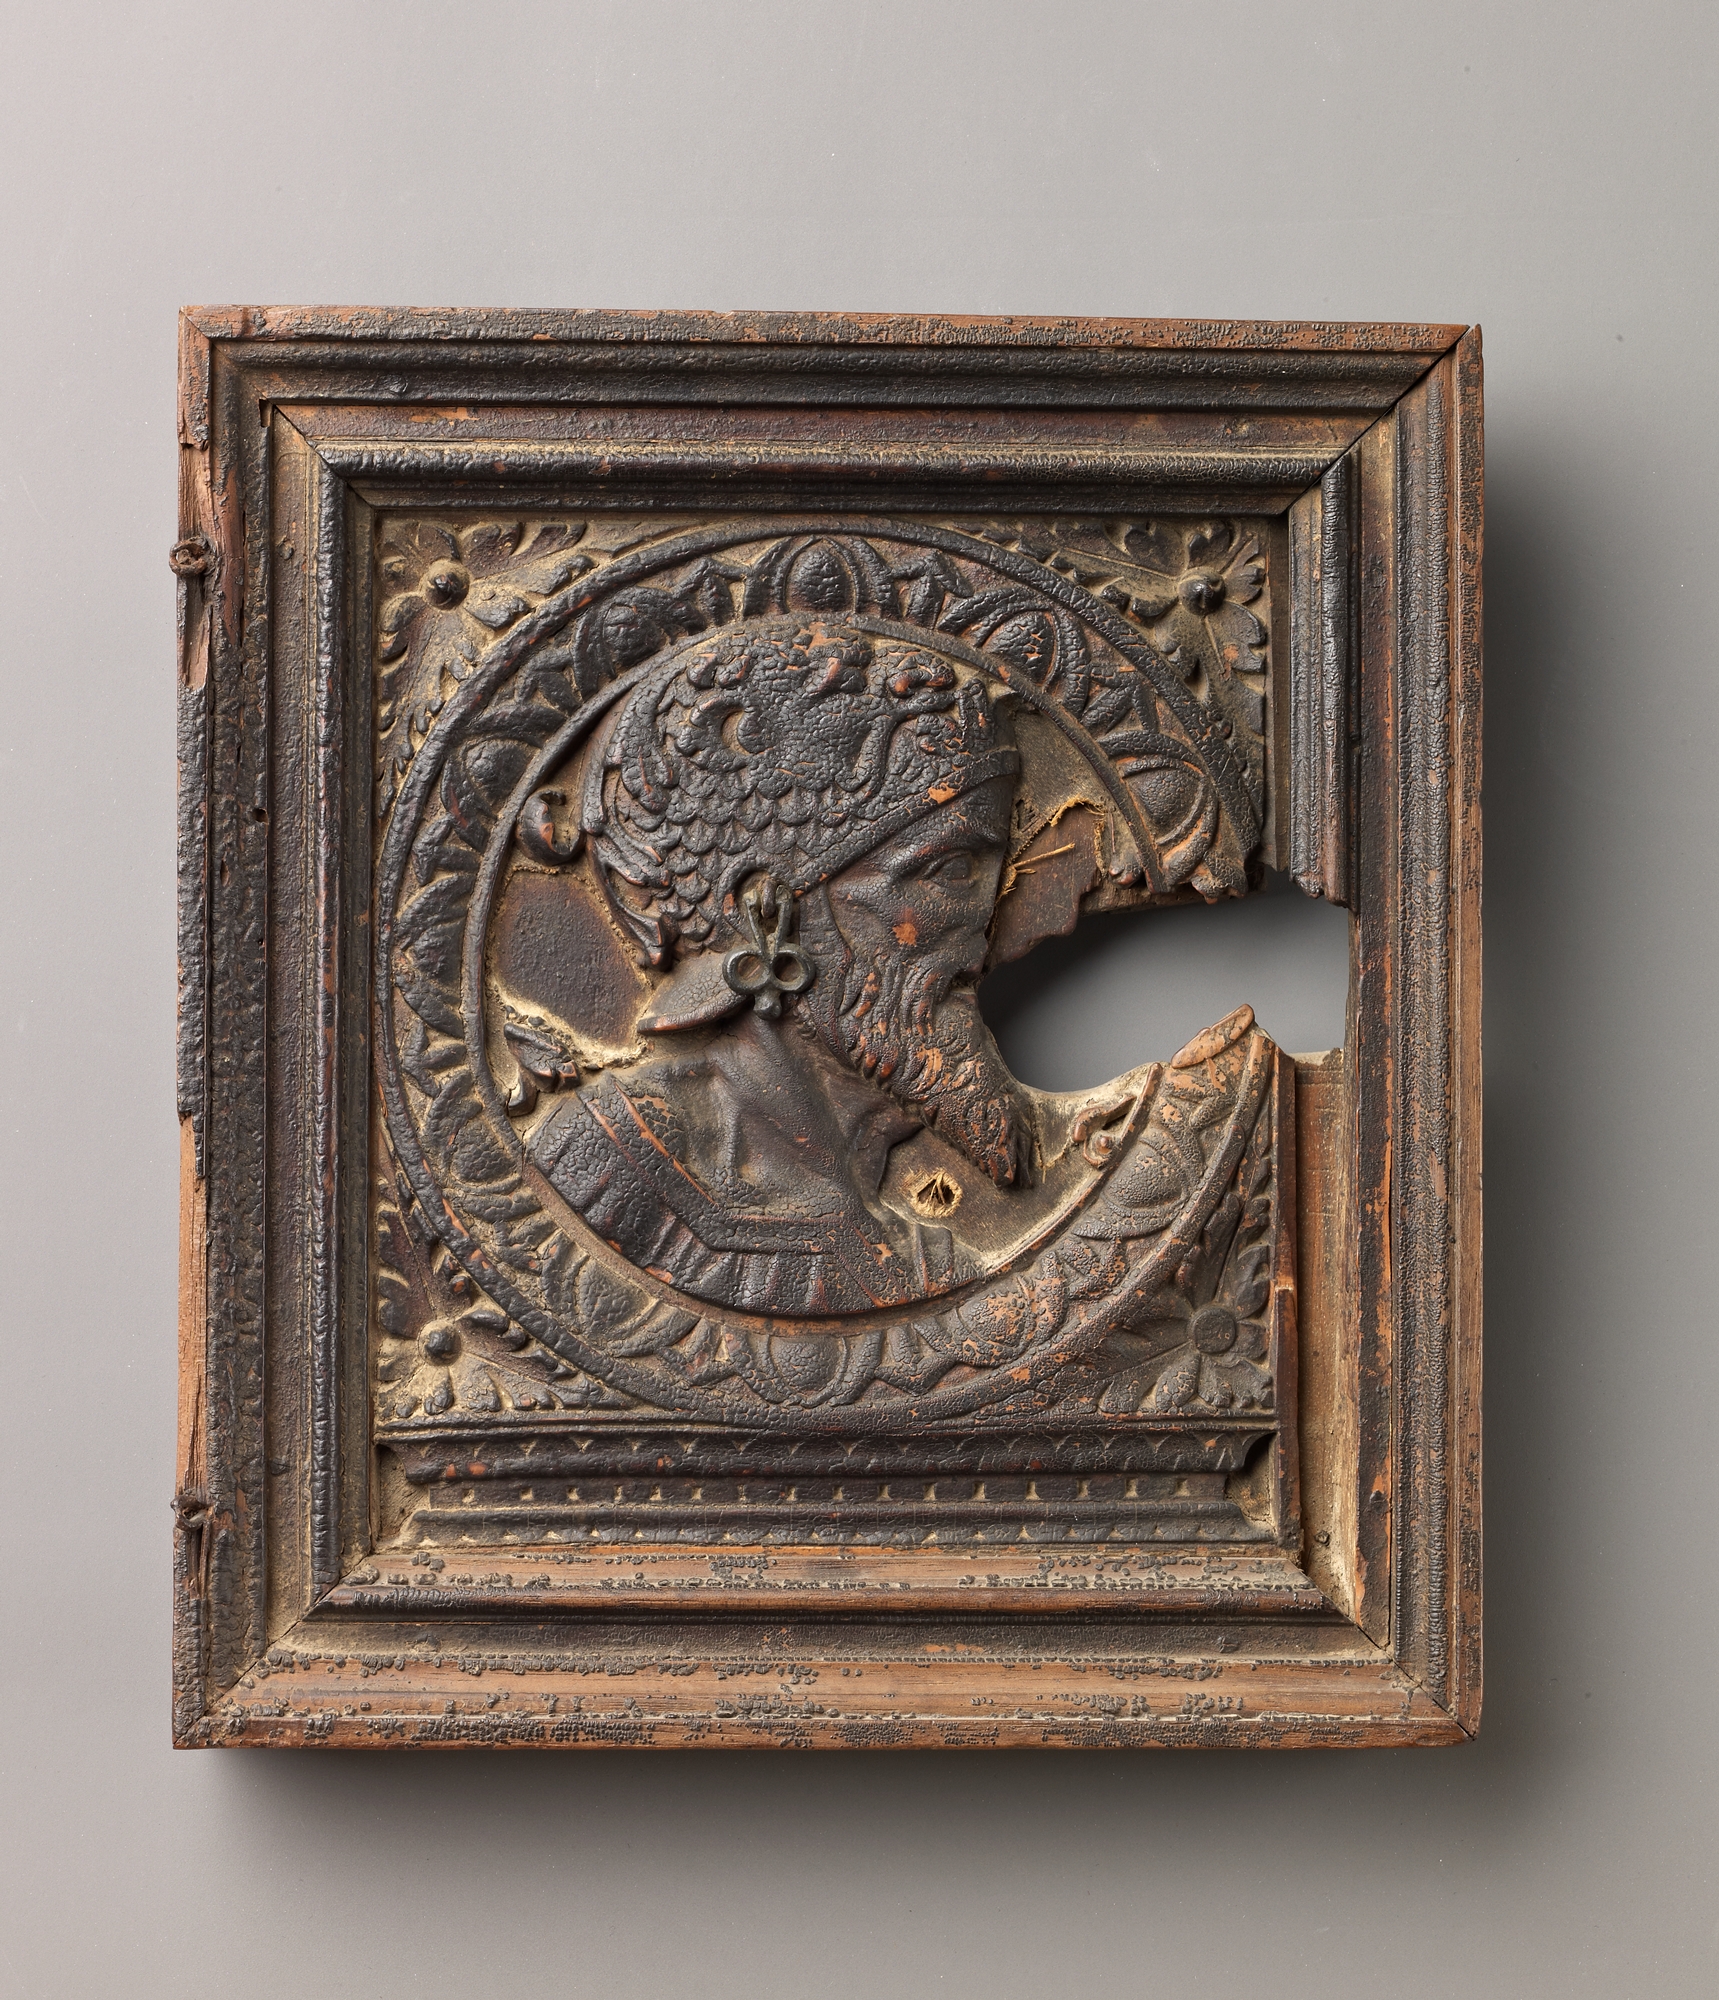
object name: cabinet door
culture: french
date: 1510-1520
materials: iron, leather, linen, wood, varnish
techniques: backing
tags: men,profiles